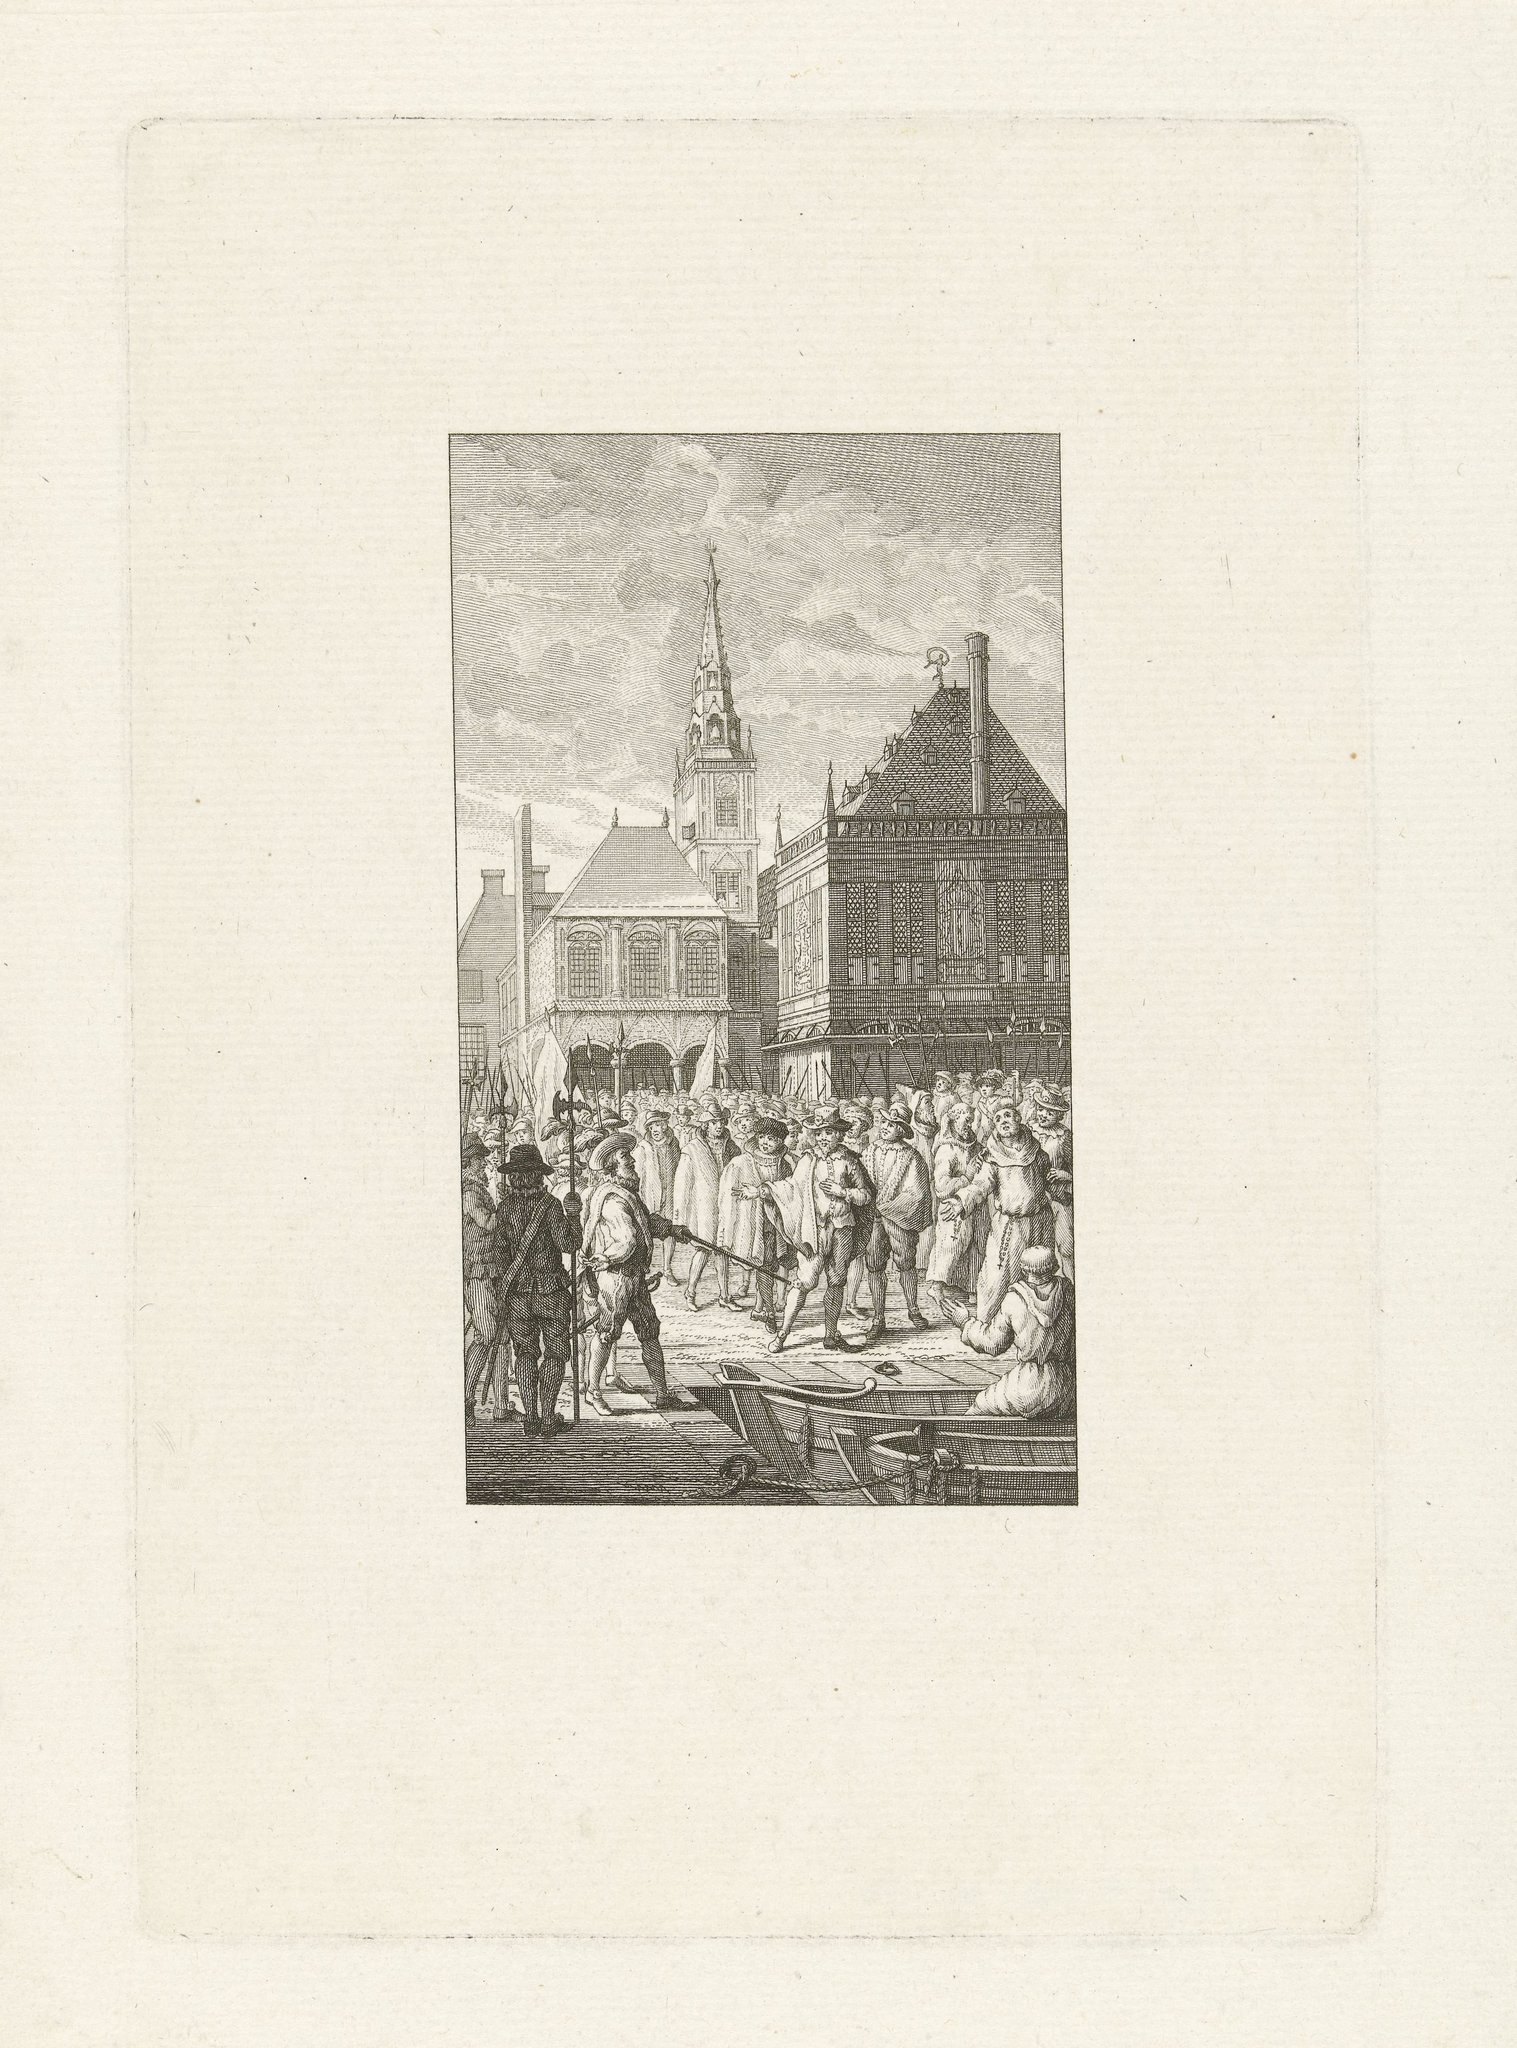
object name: print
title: Alteratie van Amsterdam, 26 mei 1578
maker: theodoor koning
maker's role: print maker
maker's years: 1748-1829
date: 1778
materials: paper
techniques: etching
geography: northern netherlands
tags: dam, stadhuis van amsterdam (14e eeuw-1652), alteratie van amsterdam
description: Alteratie van Amsterdam, 26 mei 1578. Het Spaansgezinde stadsbestuur en de roomse geestelijkheid worden gedwongen te vertrekken, op de kade bij de Dam stappen zij in gereed staande boten.